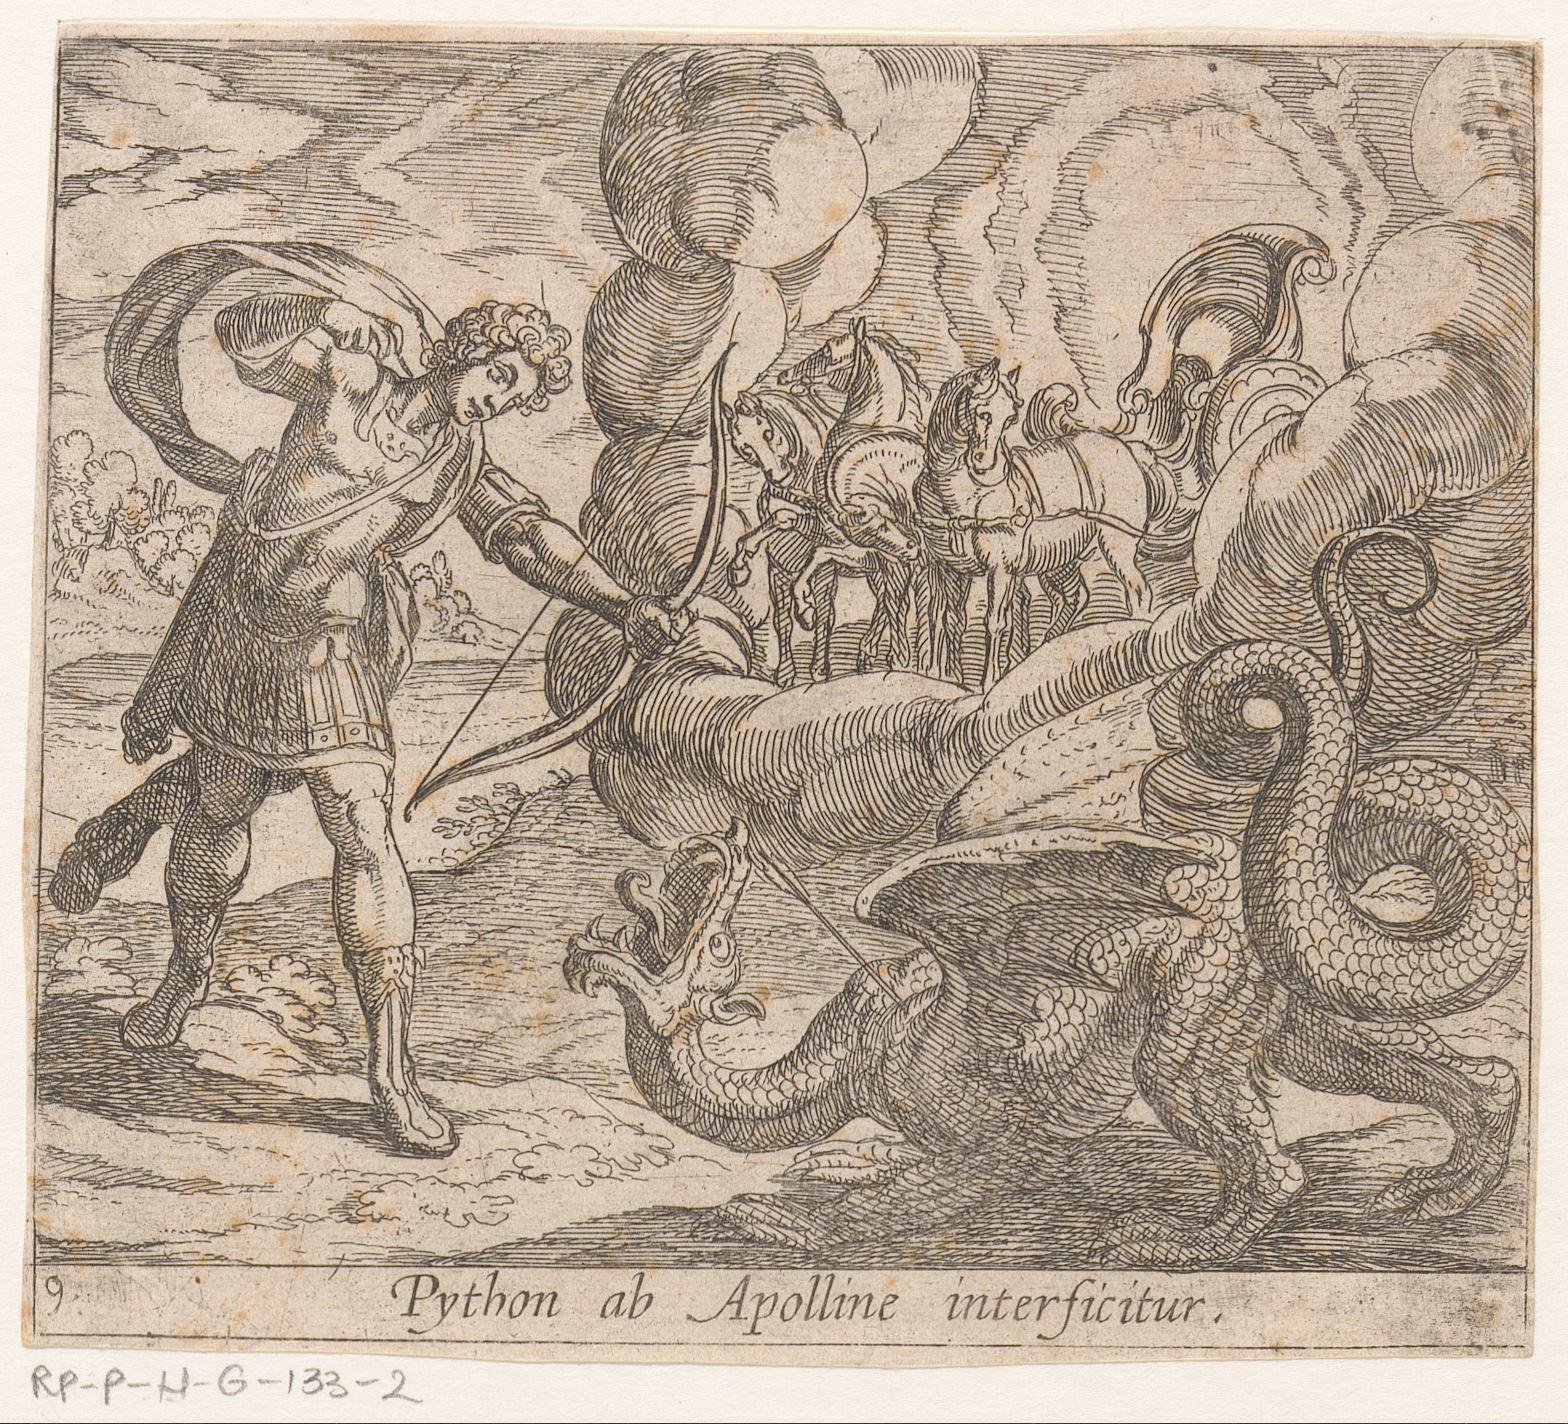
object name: print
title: Python ab Apolline interficitur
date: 1606-1638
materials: paper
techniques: etching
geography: italy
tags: apollo shoots python, the dragon, (story of) apollo (phoebus)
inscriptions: collector's mark: ‘Hinloopen’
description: Apollo schiet met pijl-en-boog op Python. Op de achtergrond de zonnewagen van Apollo met vier paarden. Titel in het Latijn in ondermarge.